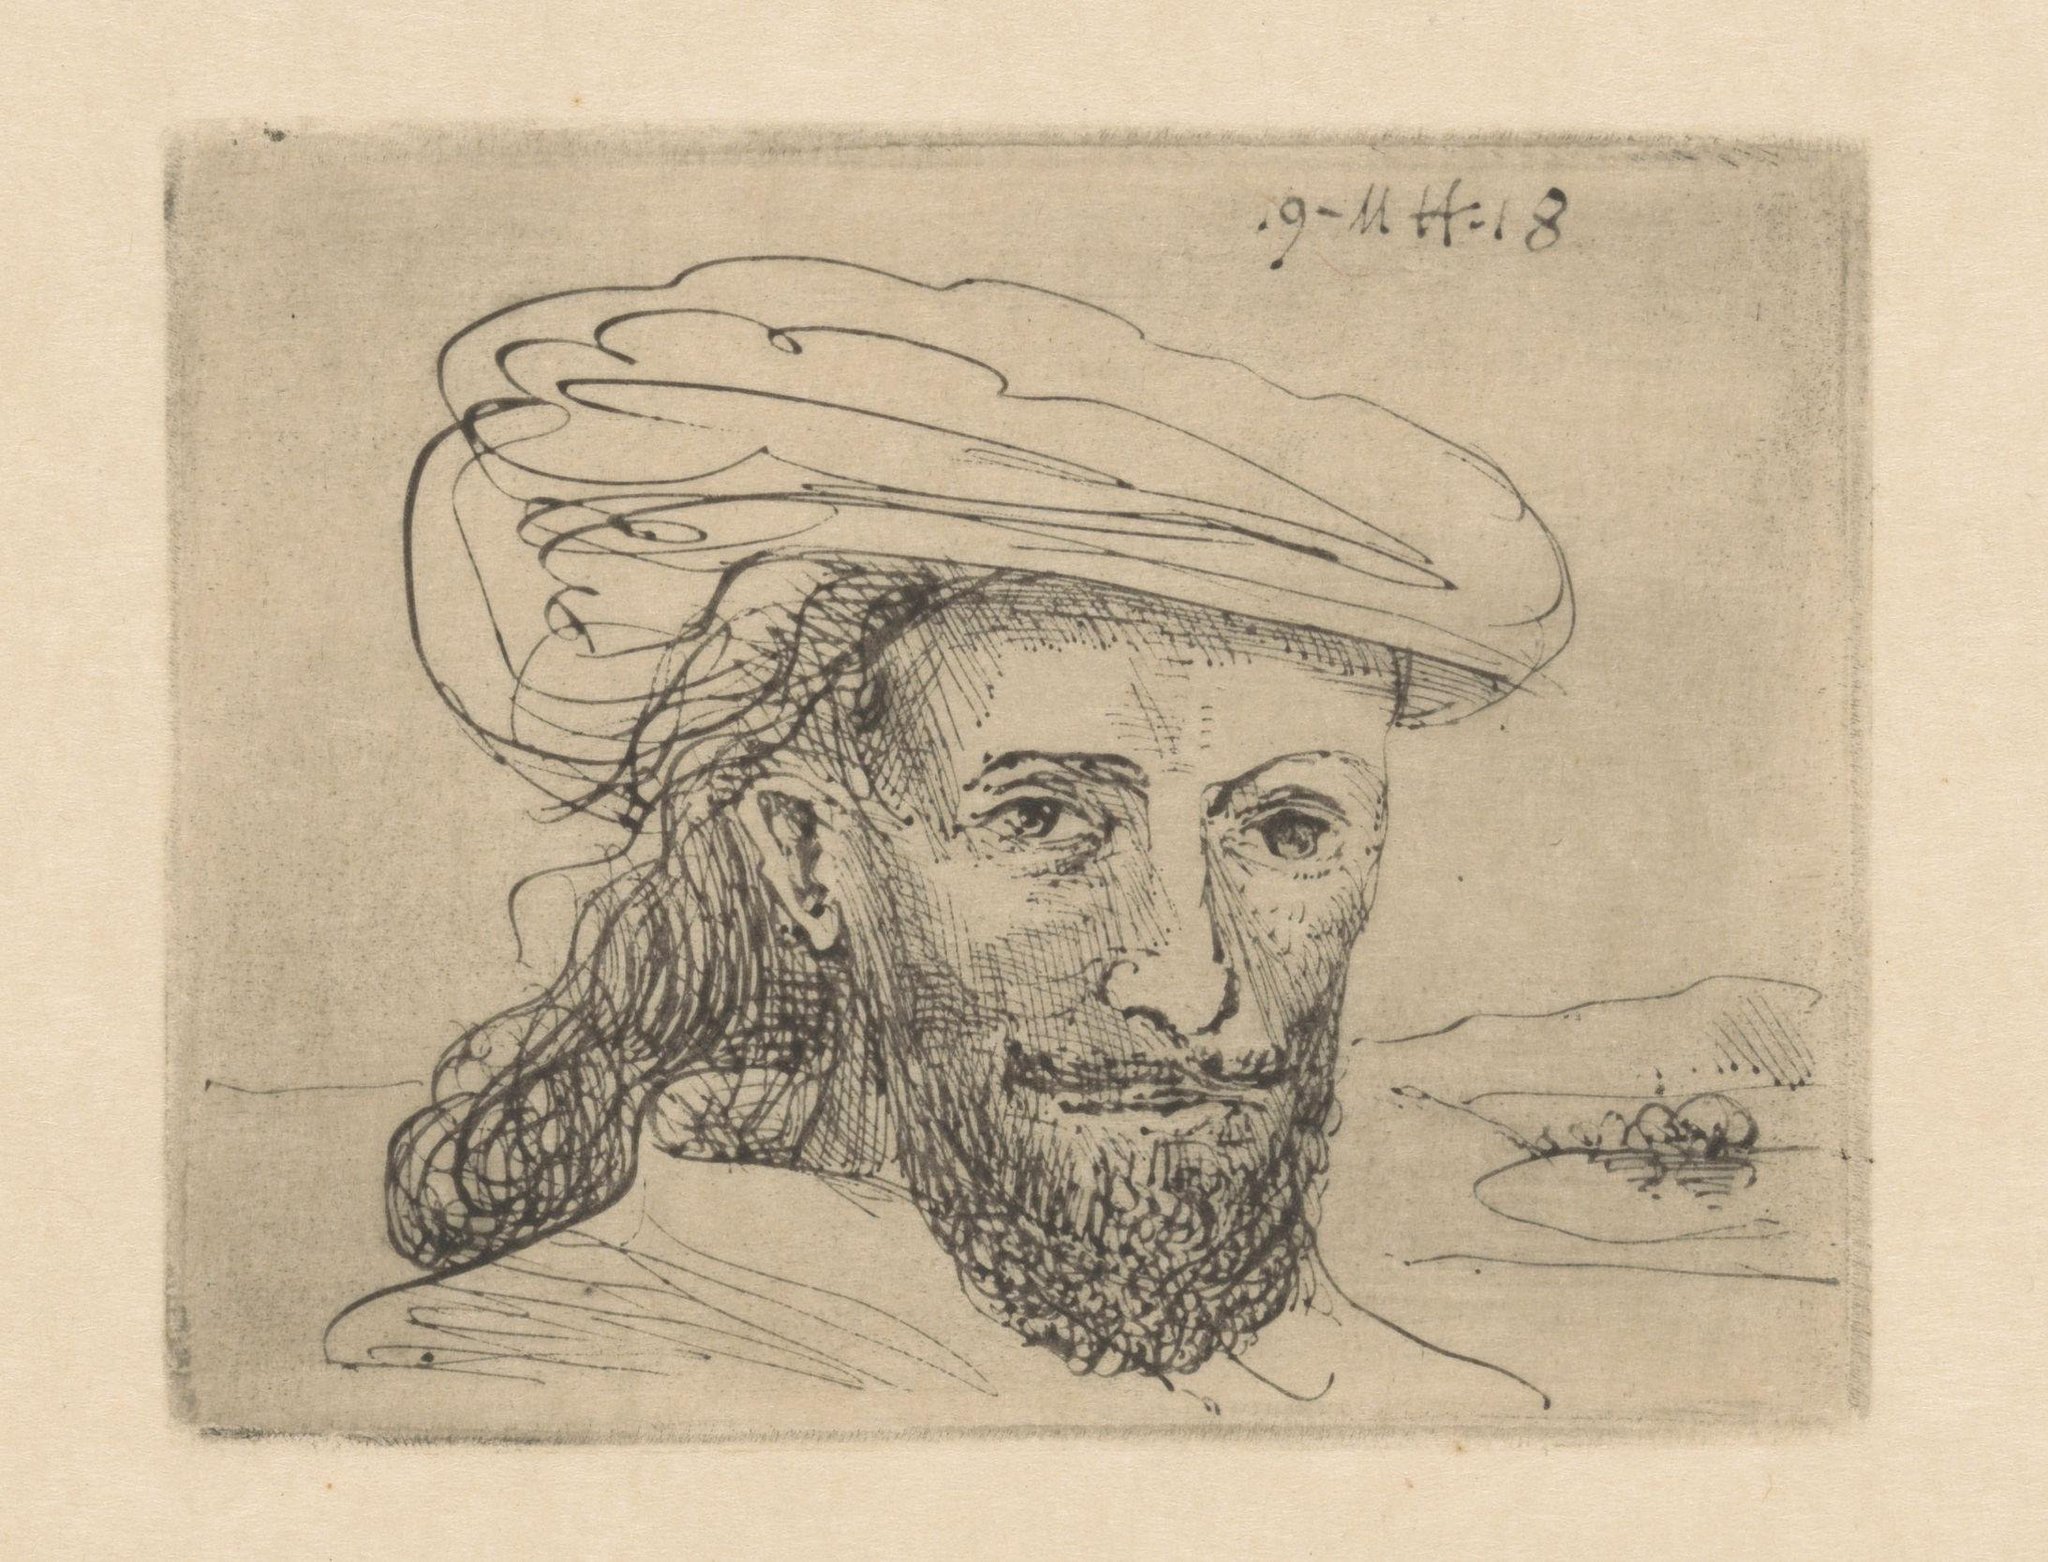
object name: print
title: Man met baard en baret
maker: marius holleman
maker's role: draughtsman, print maker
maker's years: 1878-1926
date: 1918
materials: paper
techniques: etching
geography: groningen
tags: head-gear: beret, beard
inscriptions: collector's mark: Lugt 2228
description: Op de achtergrond een heuvelachtig landschap.